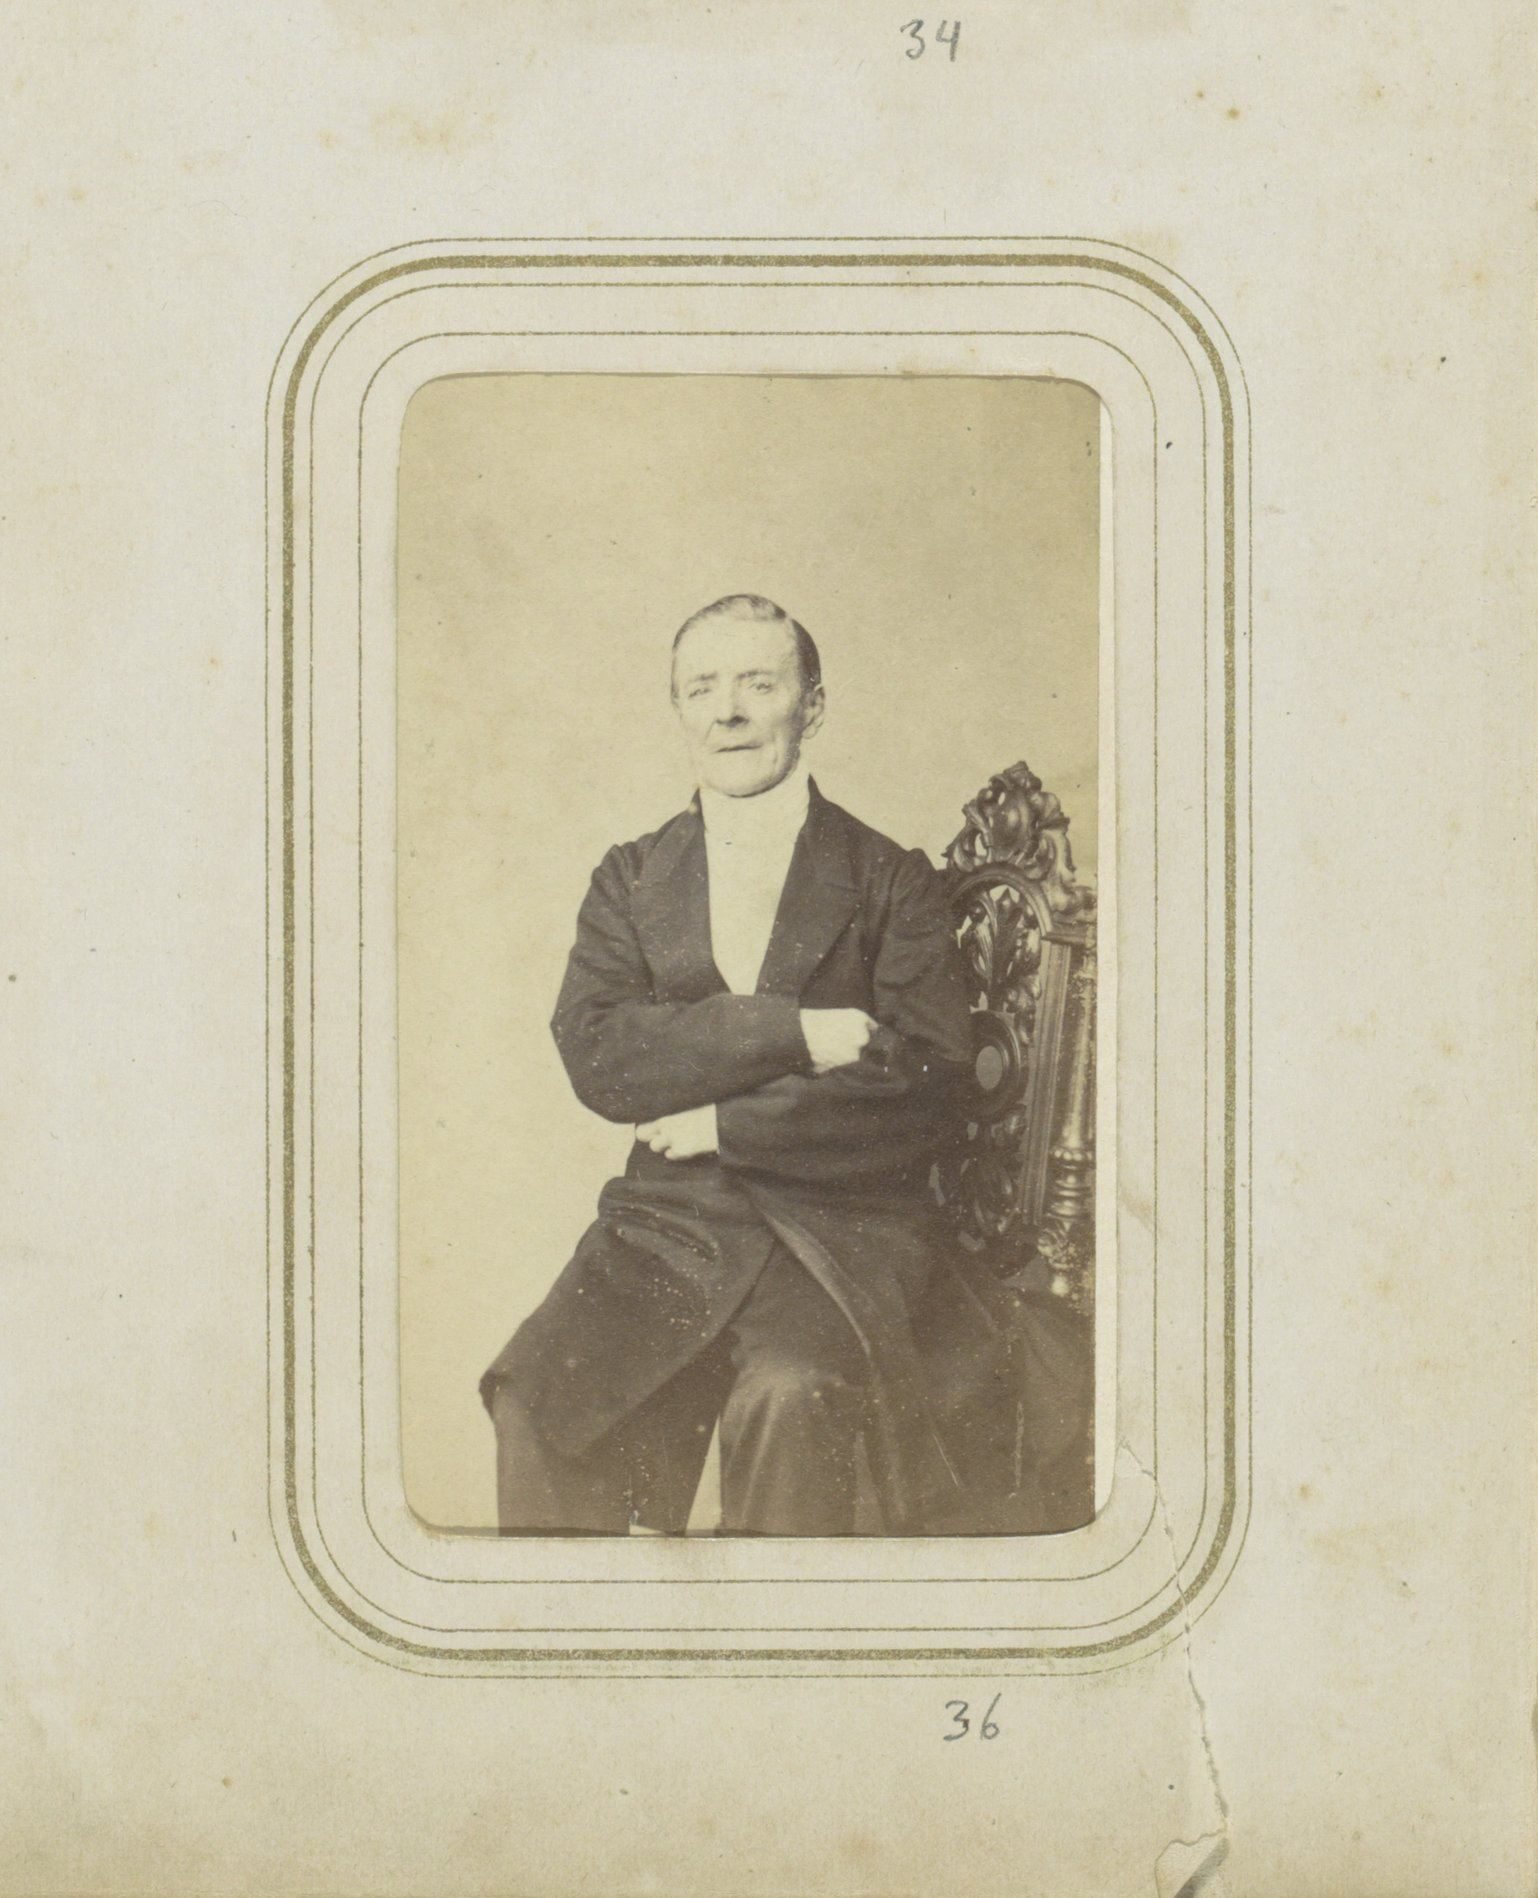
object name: carte de visite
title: Portret van een zittende man met een lange jas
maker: jacobus van koningsveld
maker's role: draughtsman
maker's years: 1824-1866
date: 1859-1866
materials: cardboard, photographic support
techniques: albumen print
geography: the hague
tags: studio requisites ~ photographer, clothing for the lower part of the body, historical persons, neck-gear ~ clothing, family, relationship, descent, hairdress, coat, cape, the hague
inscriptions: address: ‘Frederikstraat 60 La Haye’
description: Onderdeel van Familiealbum van H.W.F. Ligtenberg en L.M. Swart met 149 foto's en cartes-de-visite.